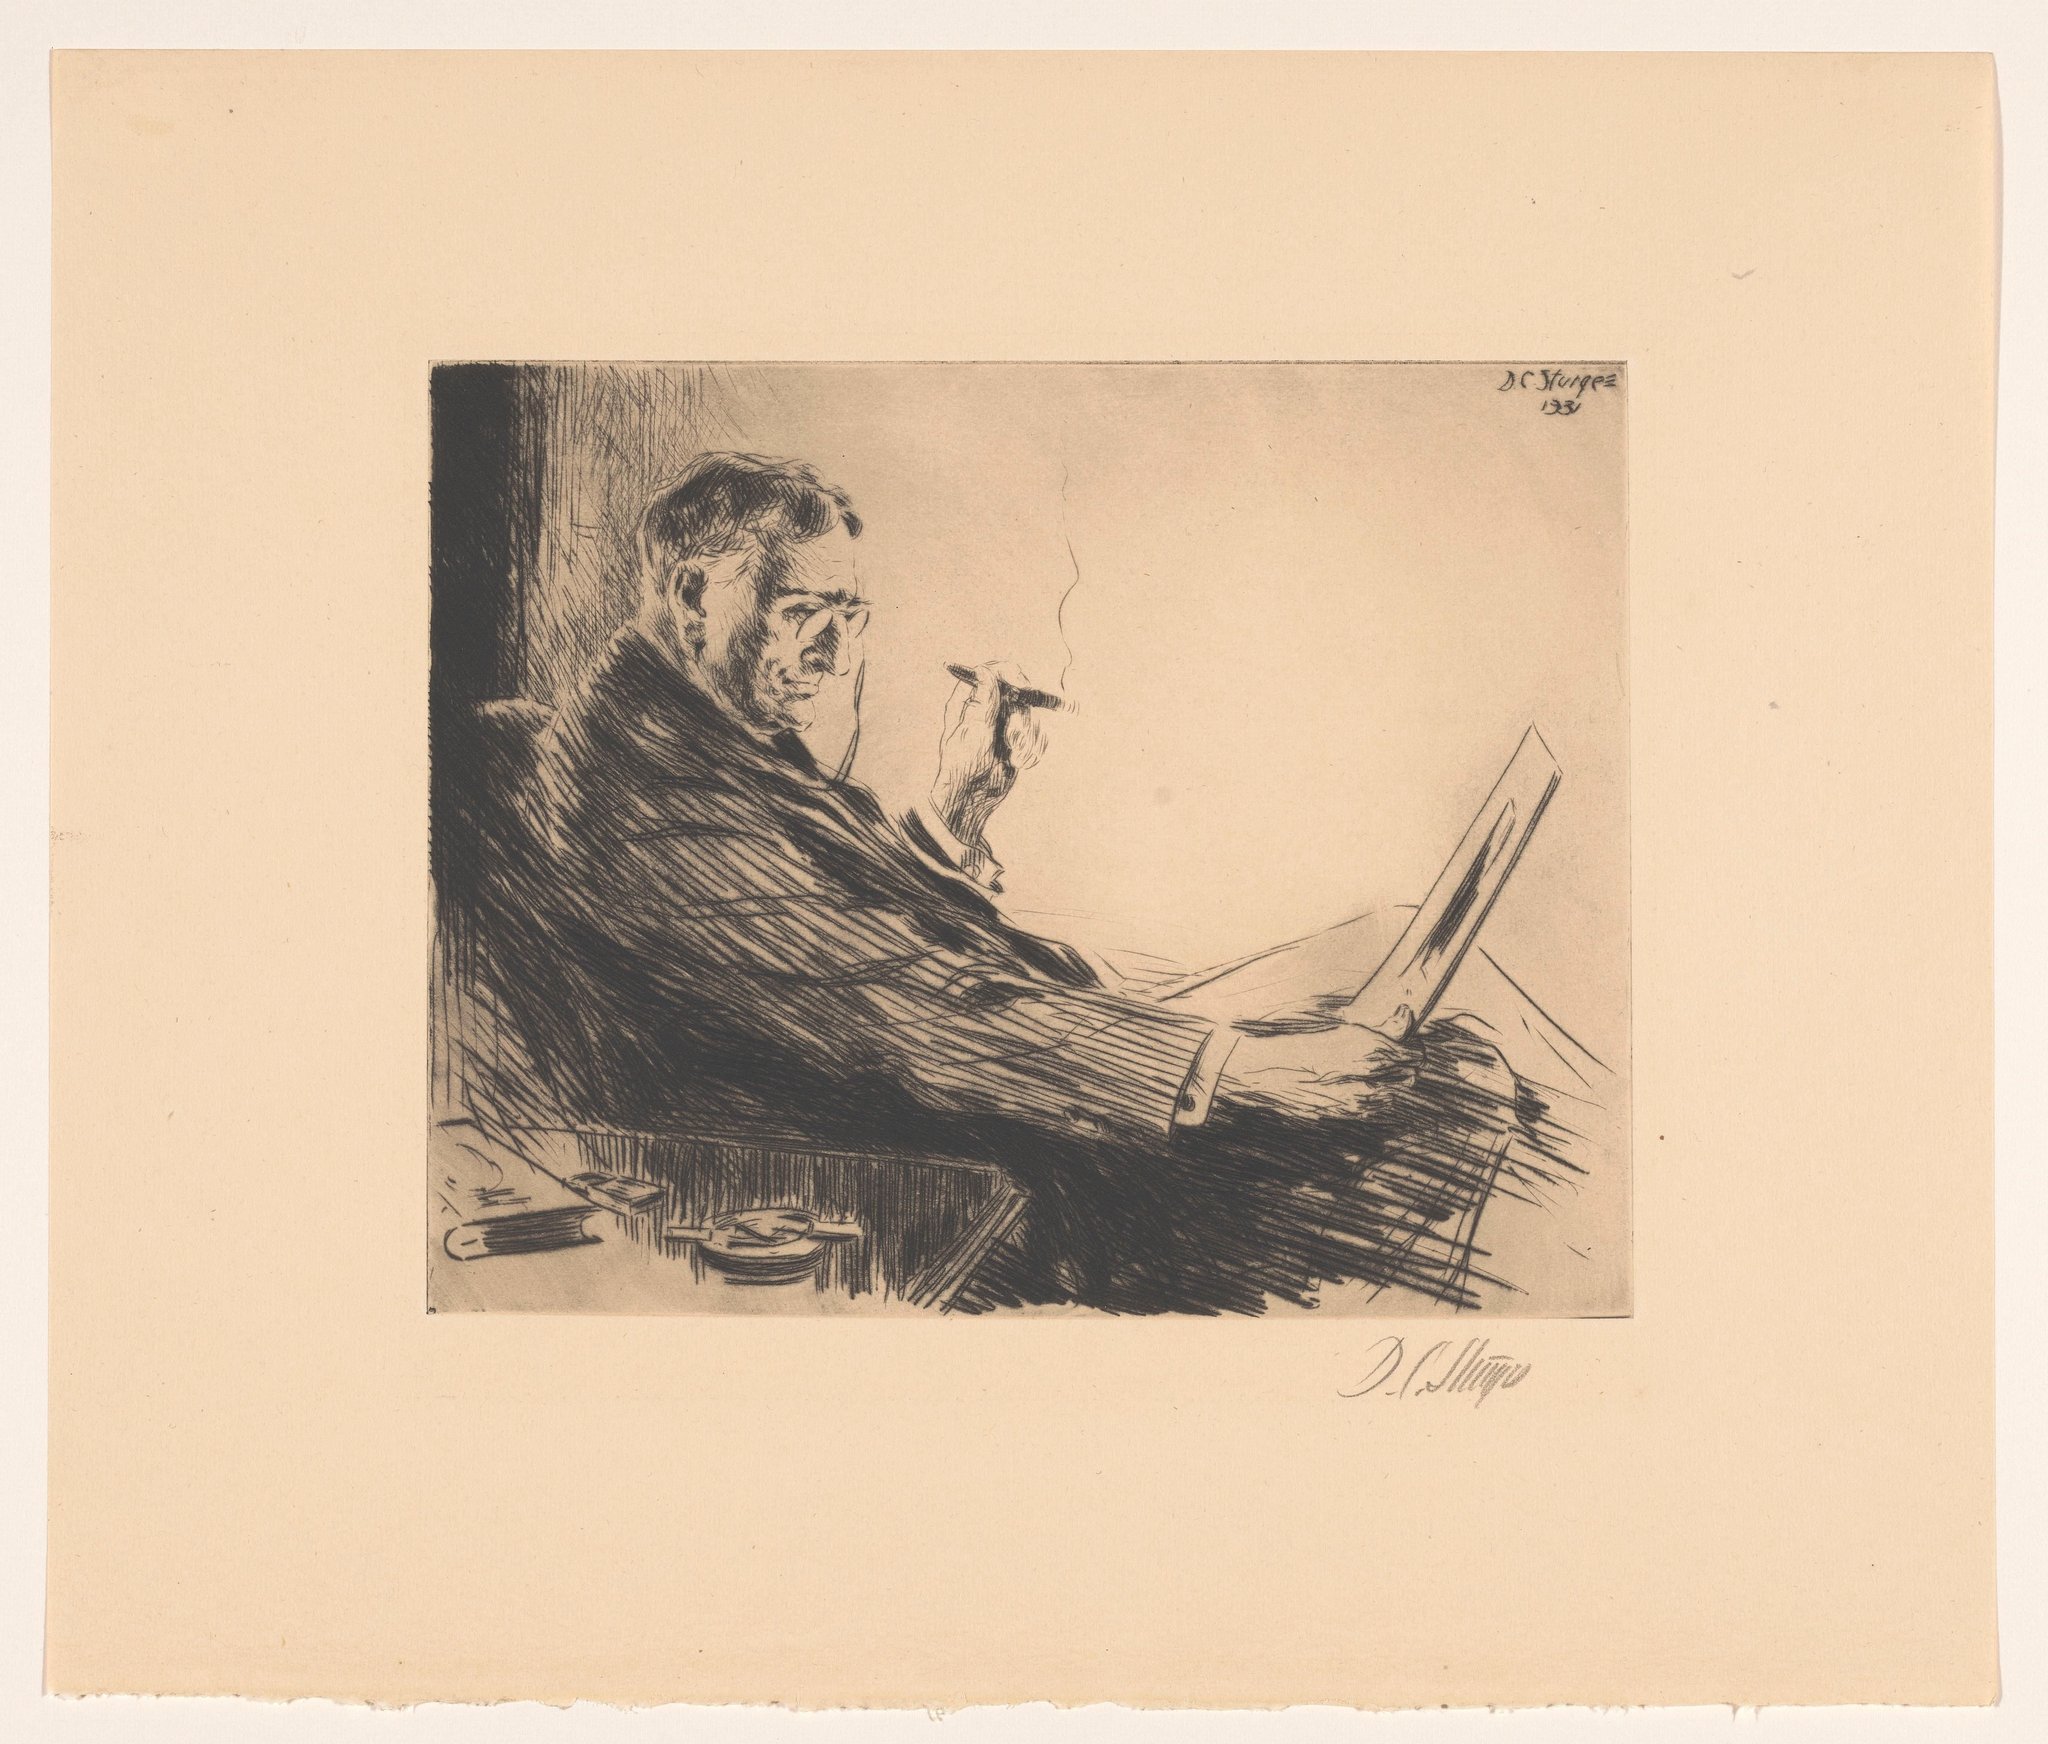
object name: print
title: The printlover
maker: dwight case sturges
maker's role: print maker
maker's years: 1874-1940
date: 1931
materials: paper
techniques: drypoint, intaglio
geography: san francisco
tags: cigar, print, e.g.: engraving, etching, lithograph, art collector (+ graphic arts)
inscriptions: collector's mark: Lugt 4779, collector's mark: Lugt 2228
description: Een zittende man met een sigaar in zijn linkerhand bekijkt een prent die hij in zijn rechterhand heeft. Op de voorgrond een tafel met een asbak en een boek.